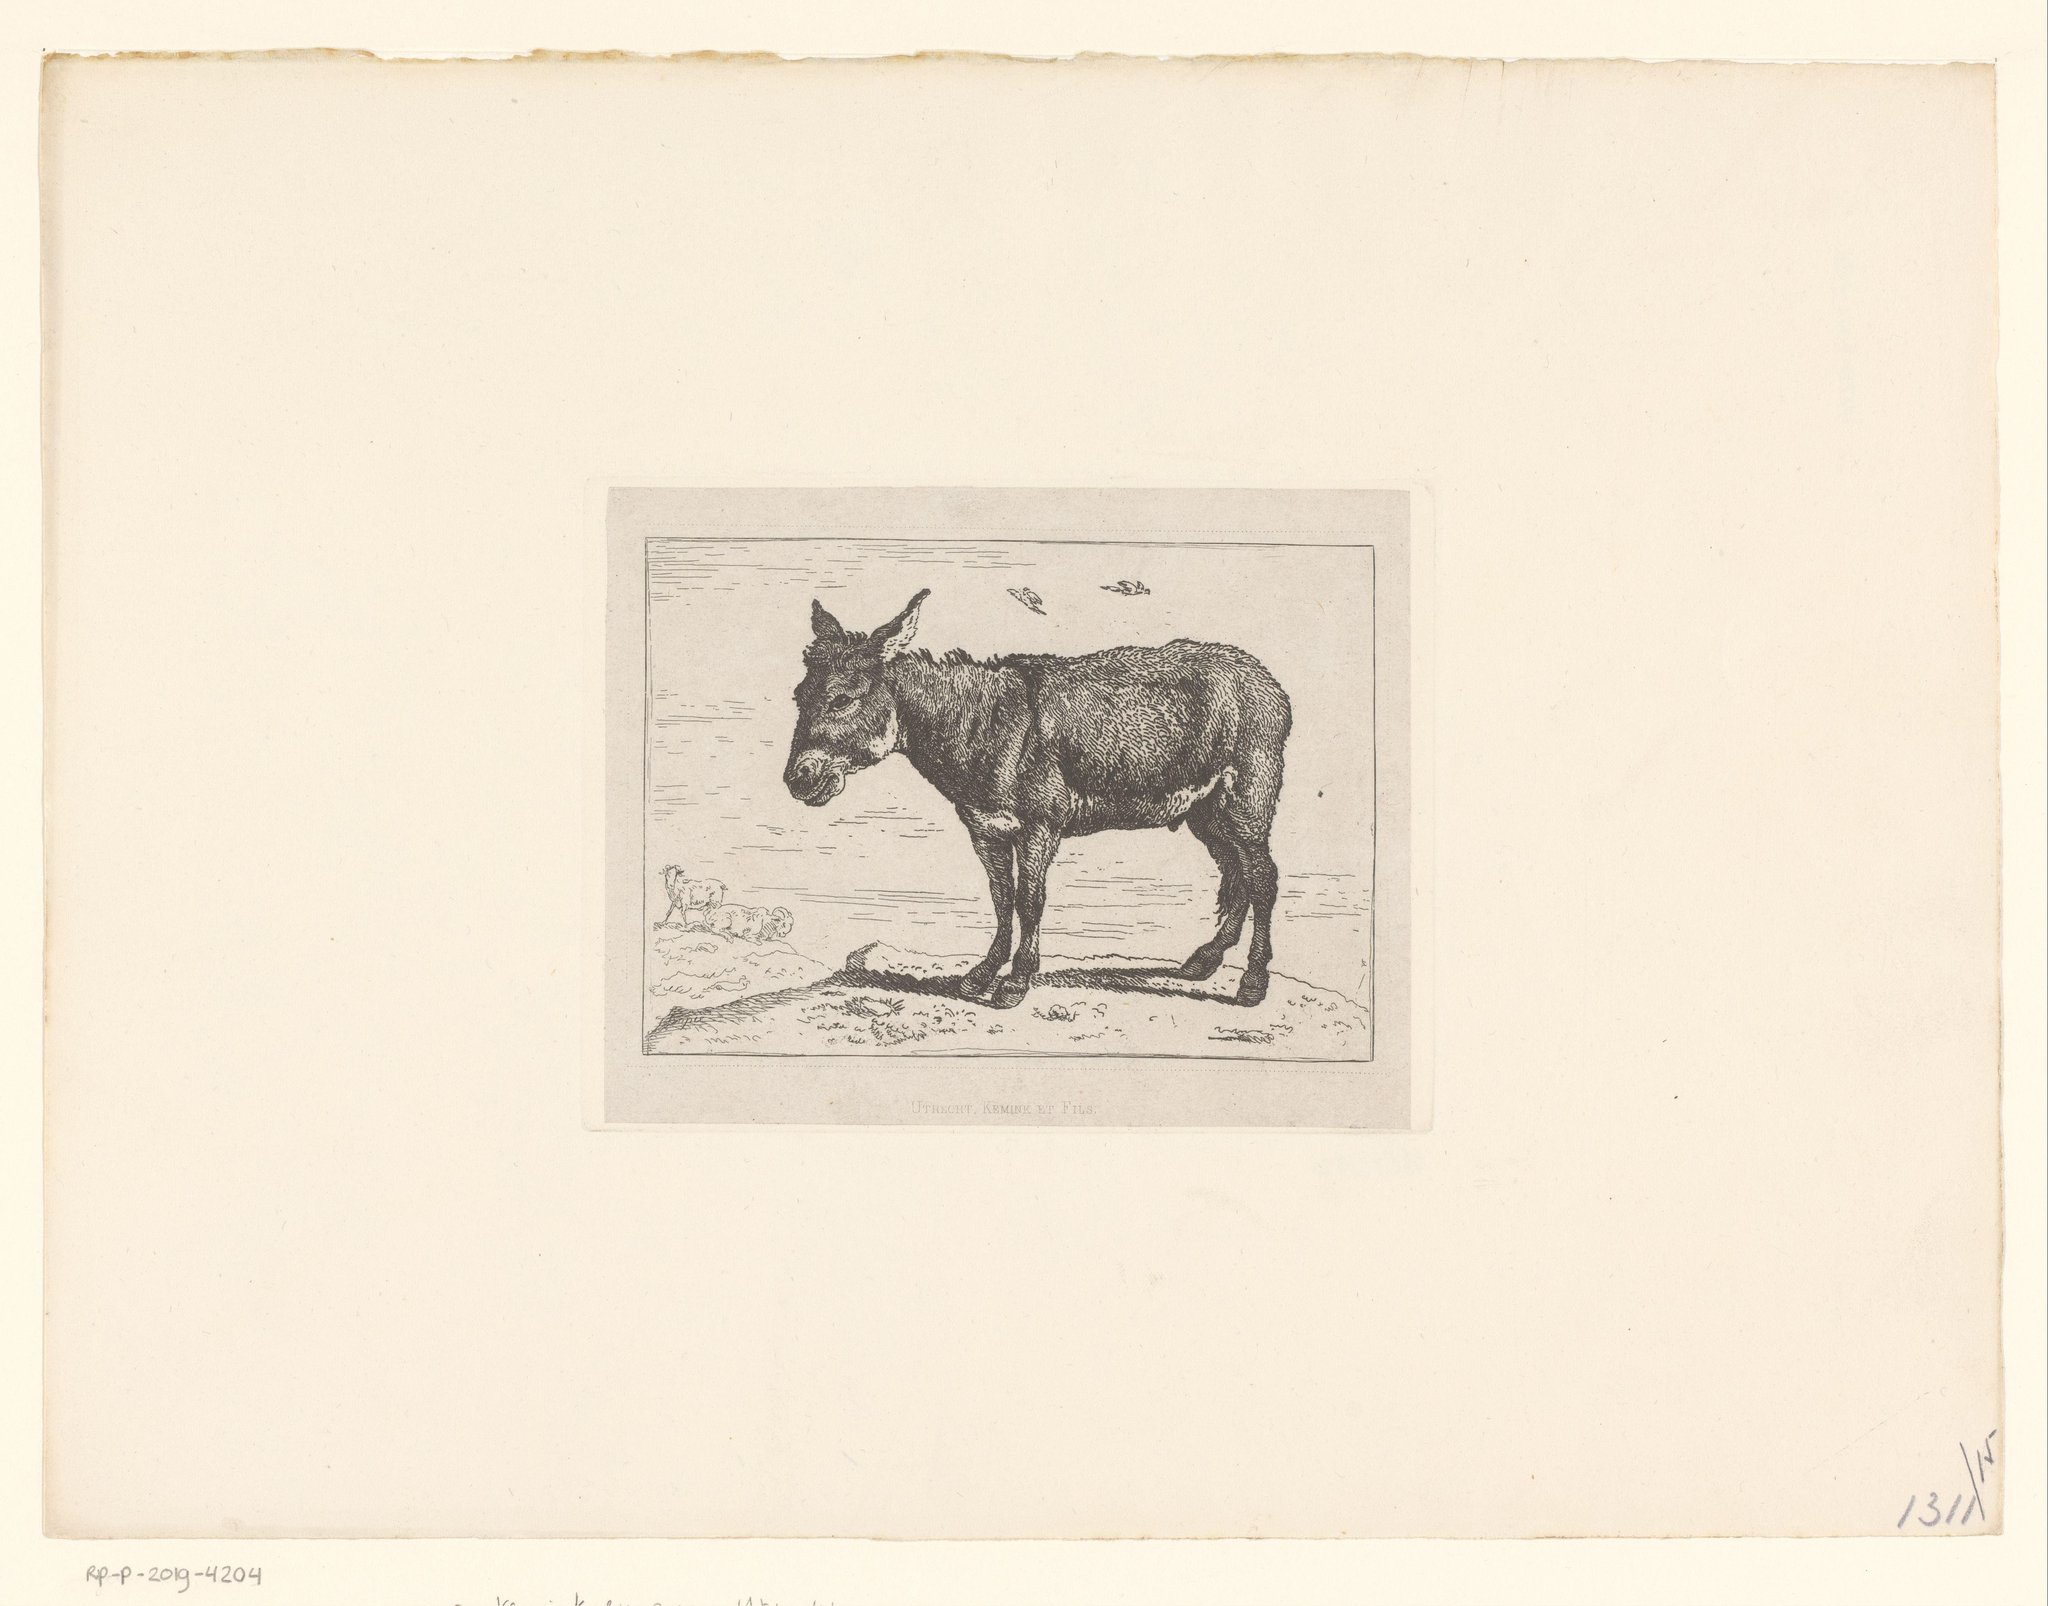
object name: book illustration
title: Staande ezel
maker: johannes arnoldus boland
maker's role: print maker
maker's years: 1838-1922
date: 1866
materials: paper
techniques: etching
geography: amsterdam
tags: ass, donkey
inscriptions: collector's mark: Lugt 2228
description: Prent uit: Kellen, J.P. van der. Le peintre-graveur Hollandais et Flamand (...). Utrecht: Kemink & Zoon, 1866, dl. 1.